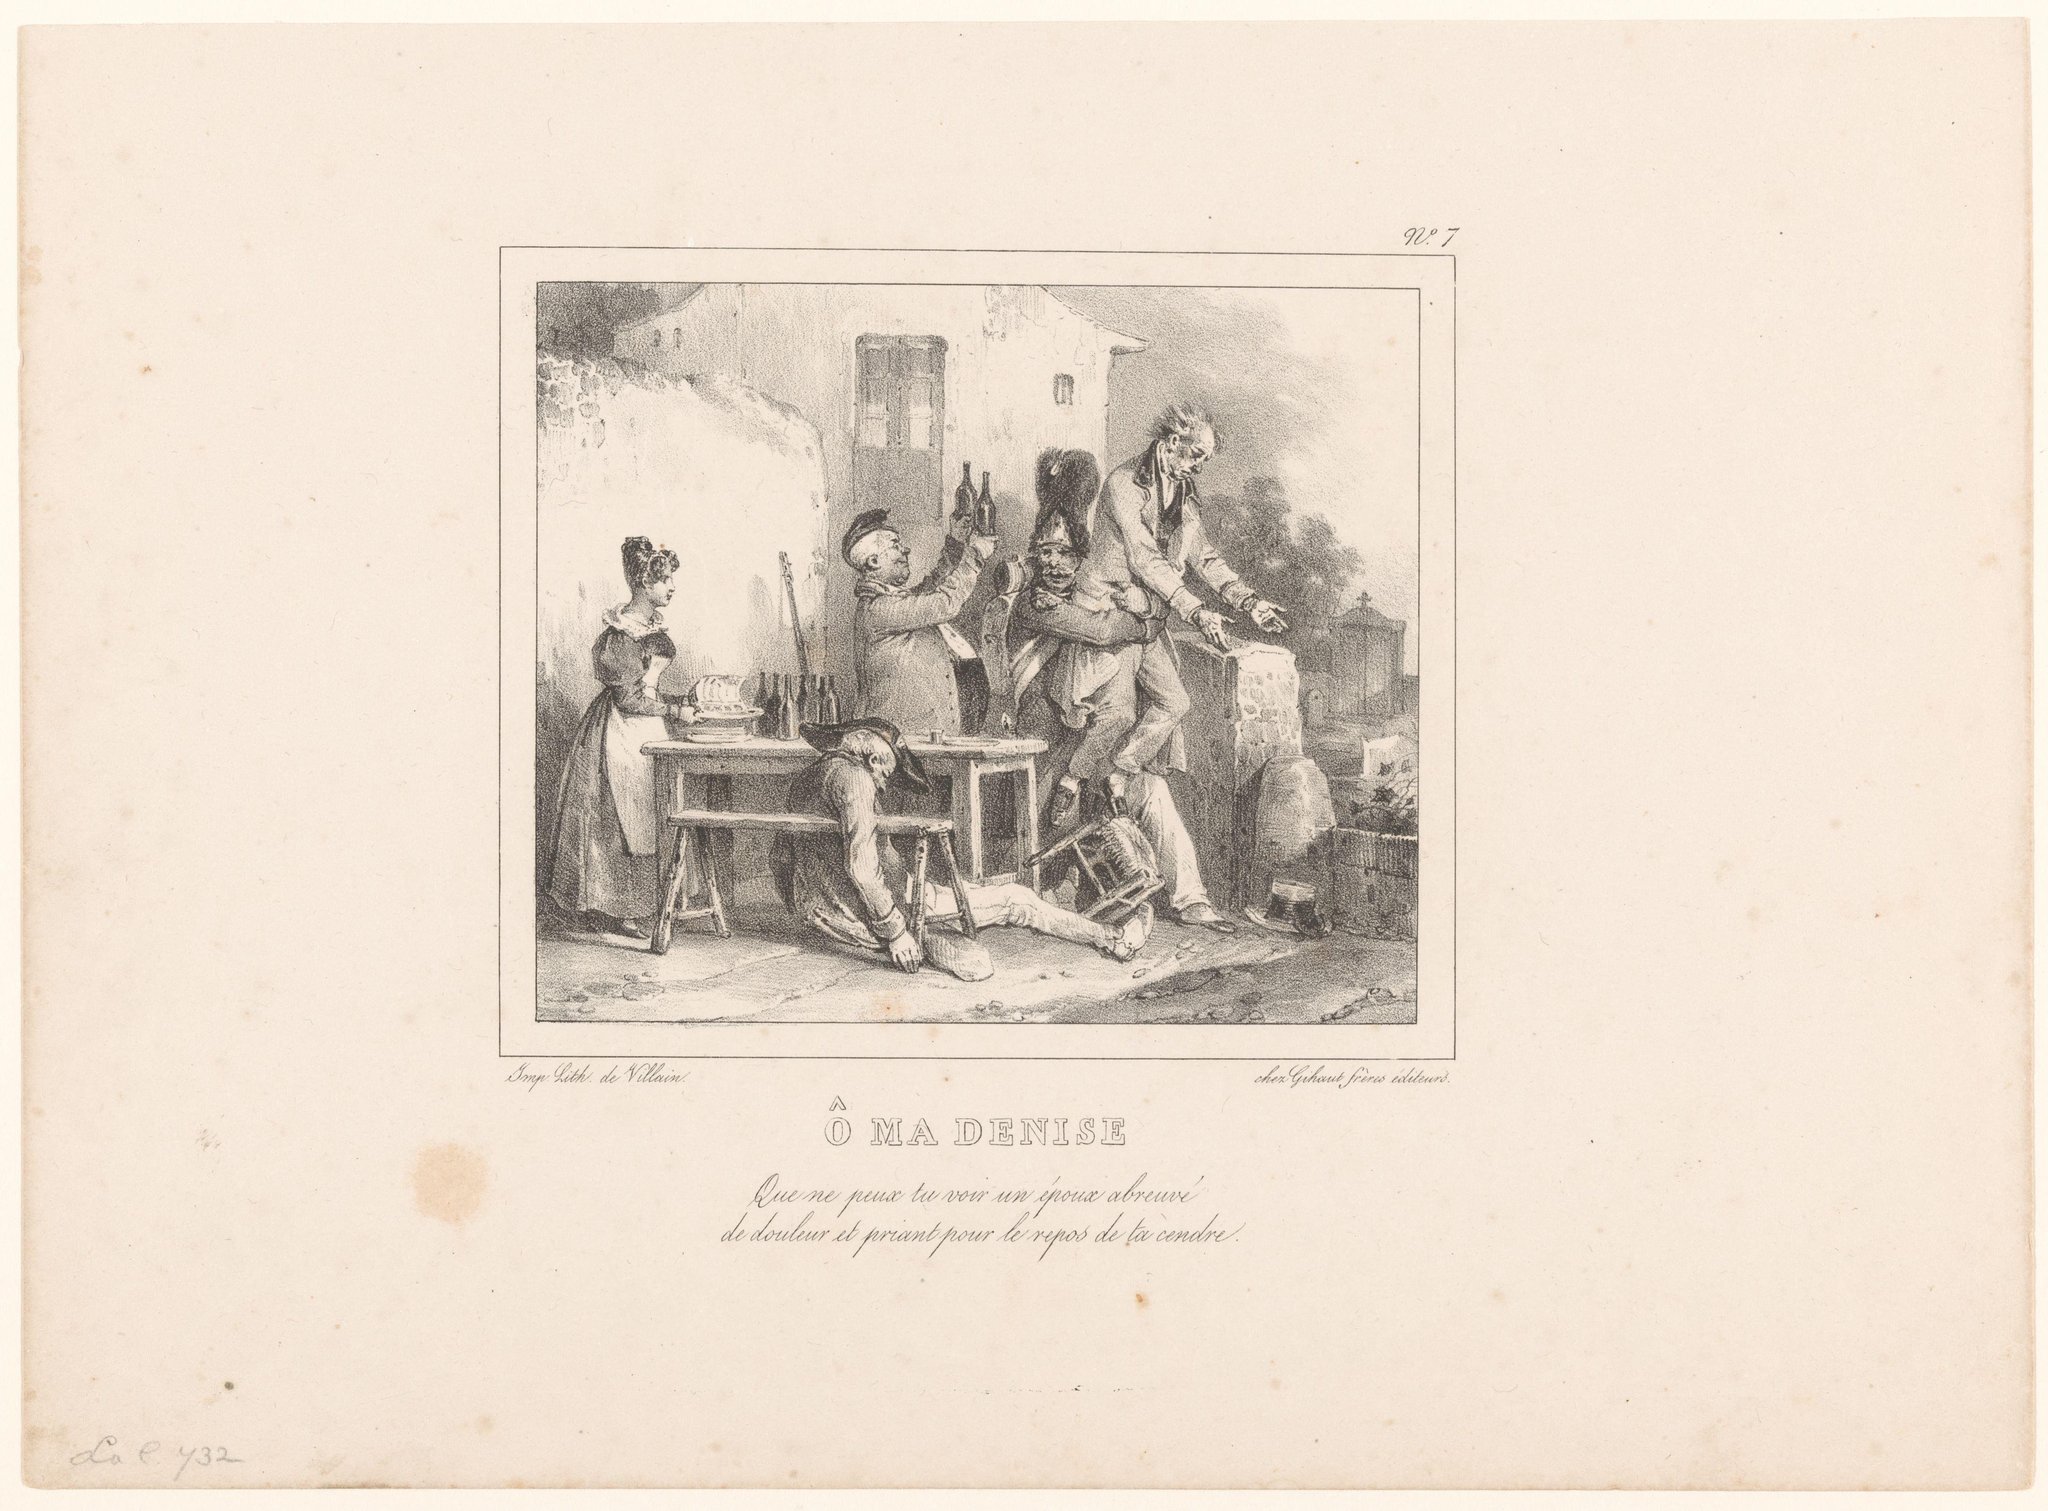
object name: cartoon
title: Ô ma Denise (...)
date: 1829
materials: paper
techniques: lithograph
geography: paris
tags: drunkard, inn, coffee-house, public house, etc., churchyard, cemetery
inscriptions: collector's mark: Lugt 2228a